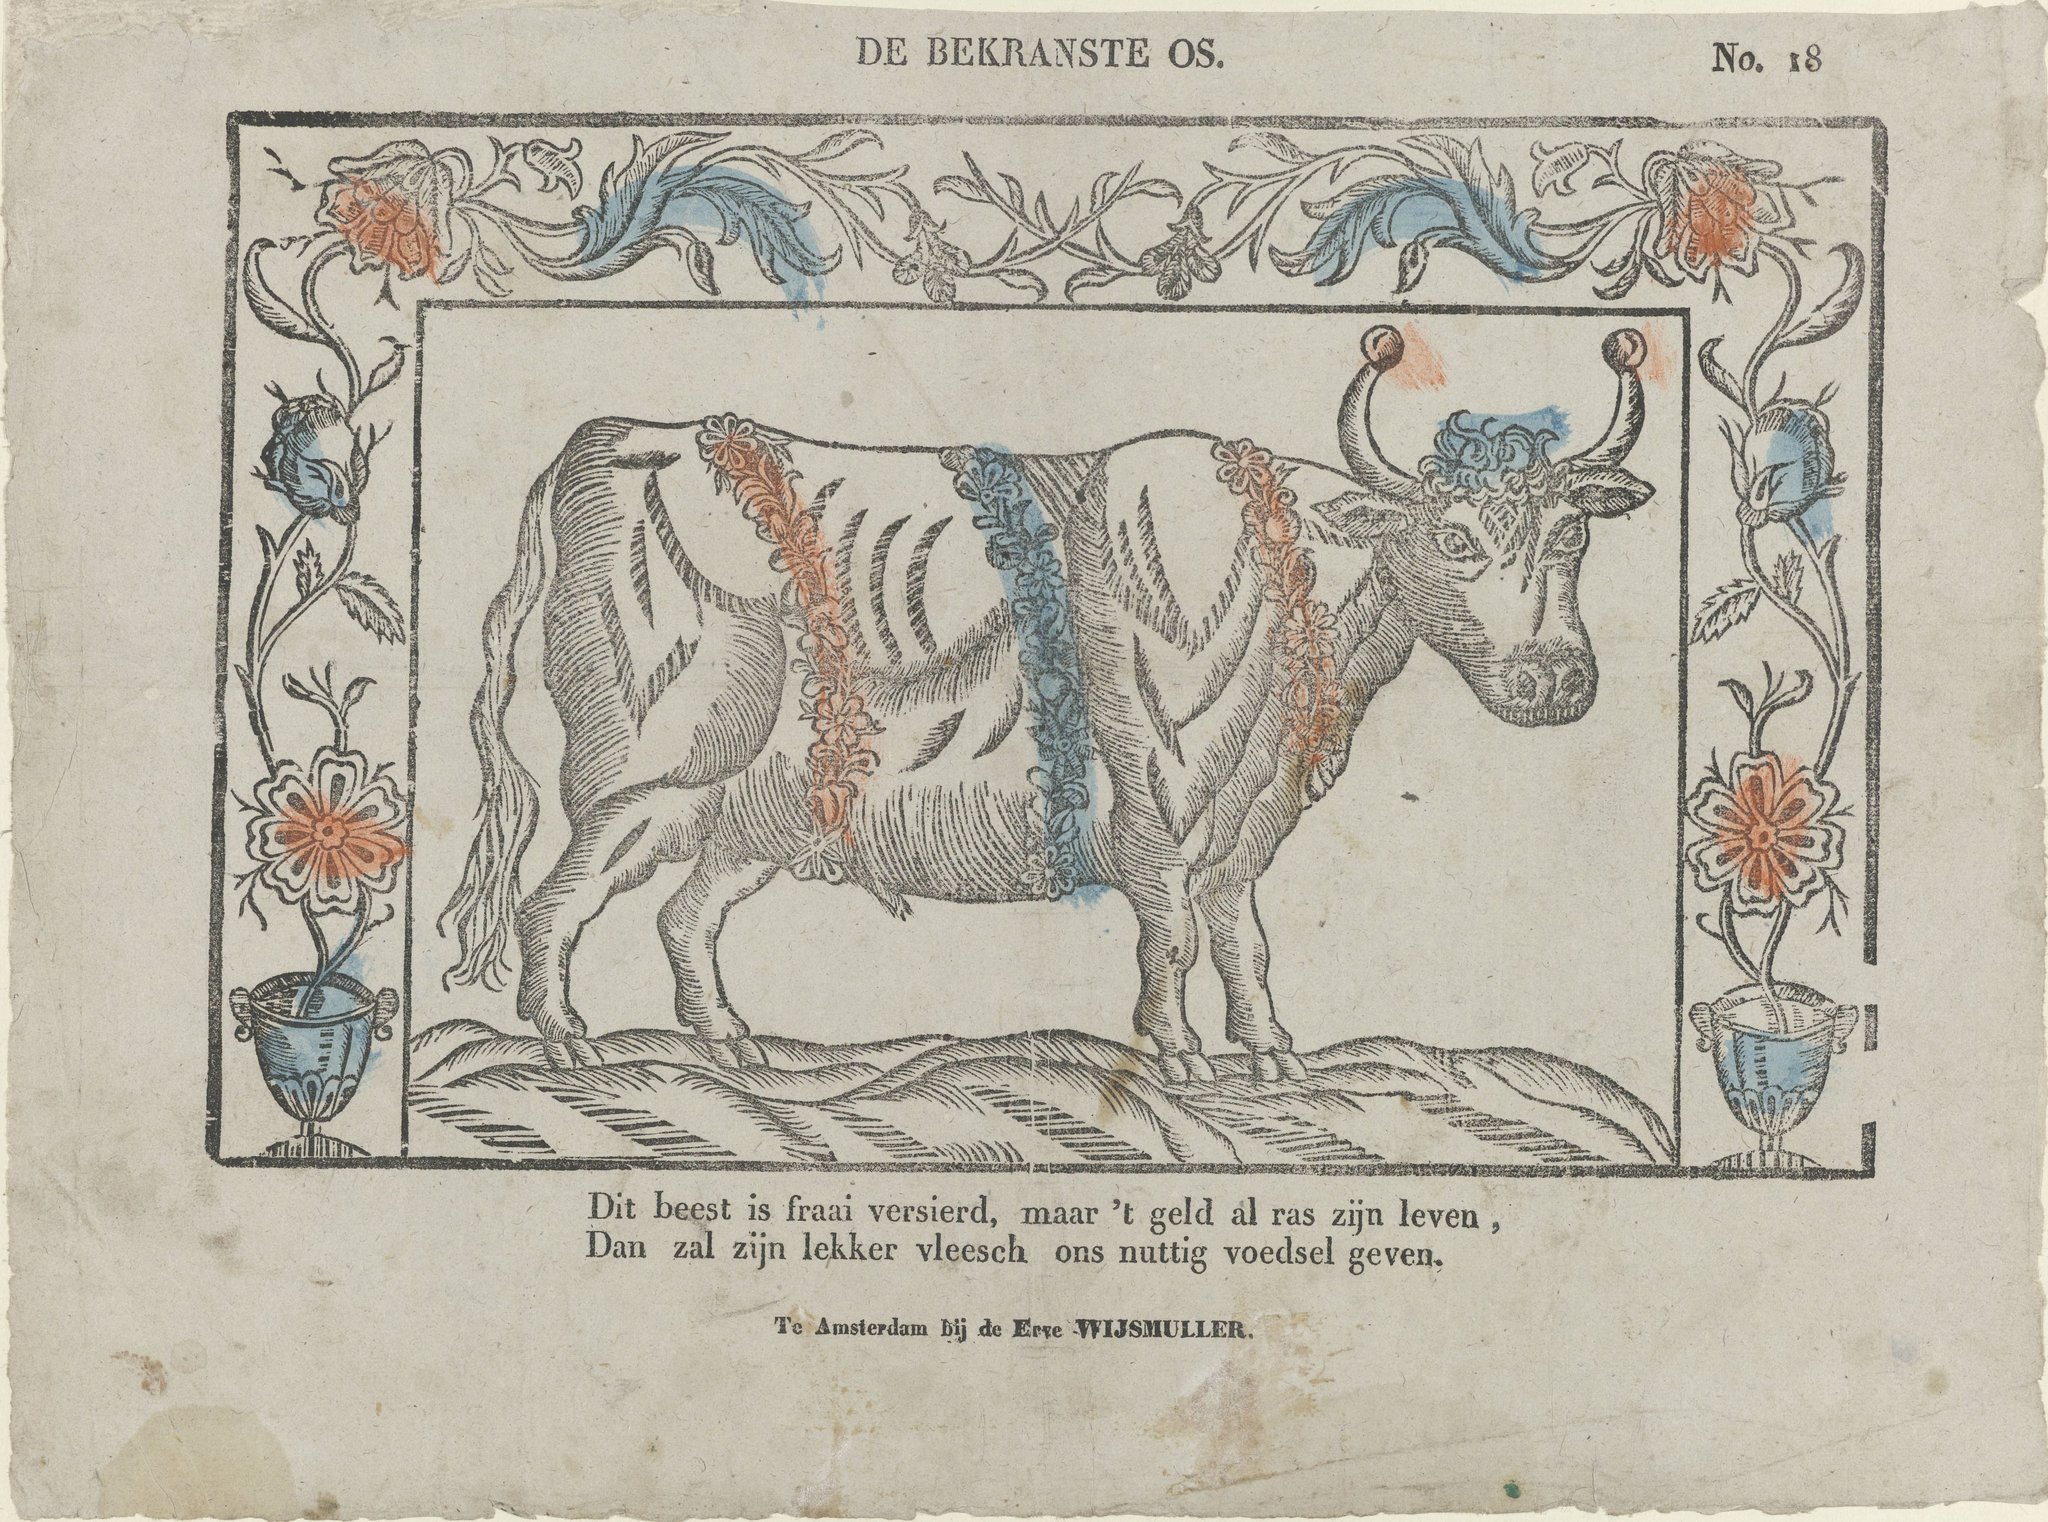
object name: popular print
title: De bekranste os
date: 1832-1850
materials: paper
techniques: colour, letterpress printing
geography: rotterdam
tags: floral interlace ~ ornament, prize-ox, ox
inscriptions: collector's mark: Lugt 2760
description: Blad met een grote voorstelling van een gilde-os (ook kermisos of prijsos genoemd), versierd met bloemenkransen. De voorstelling is gevat in een lijst met bloemenranken en kelken. Onder de voorstelling een tweeregelig vers. Genummerd rechtsboven: No. 18.